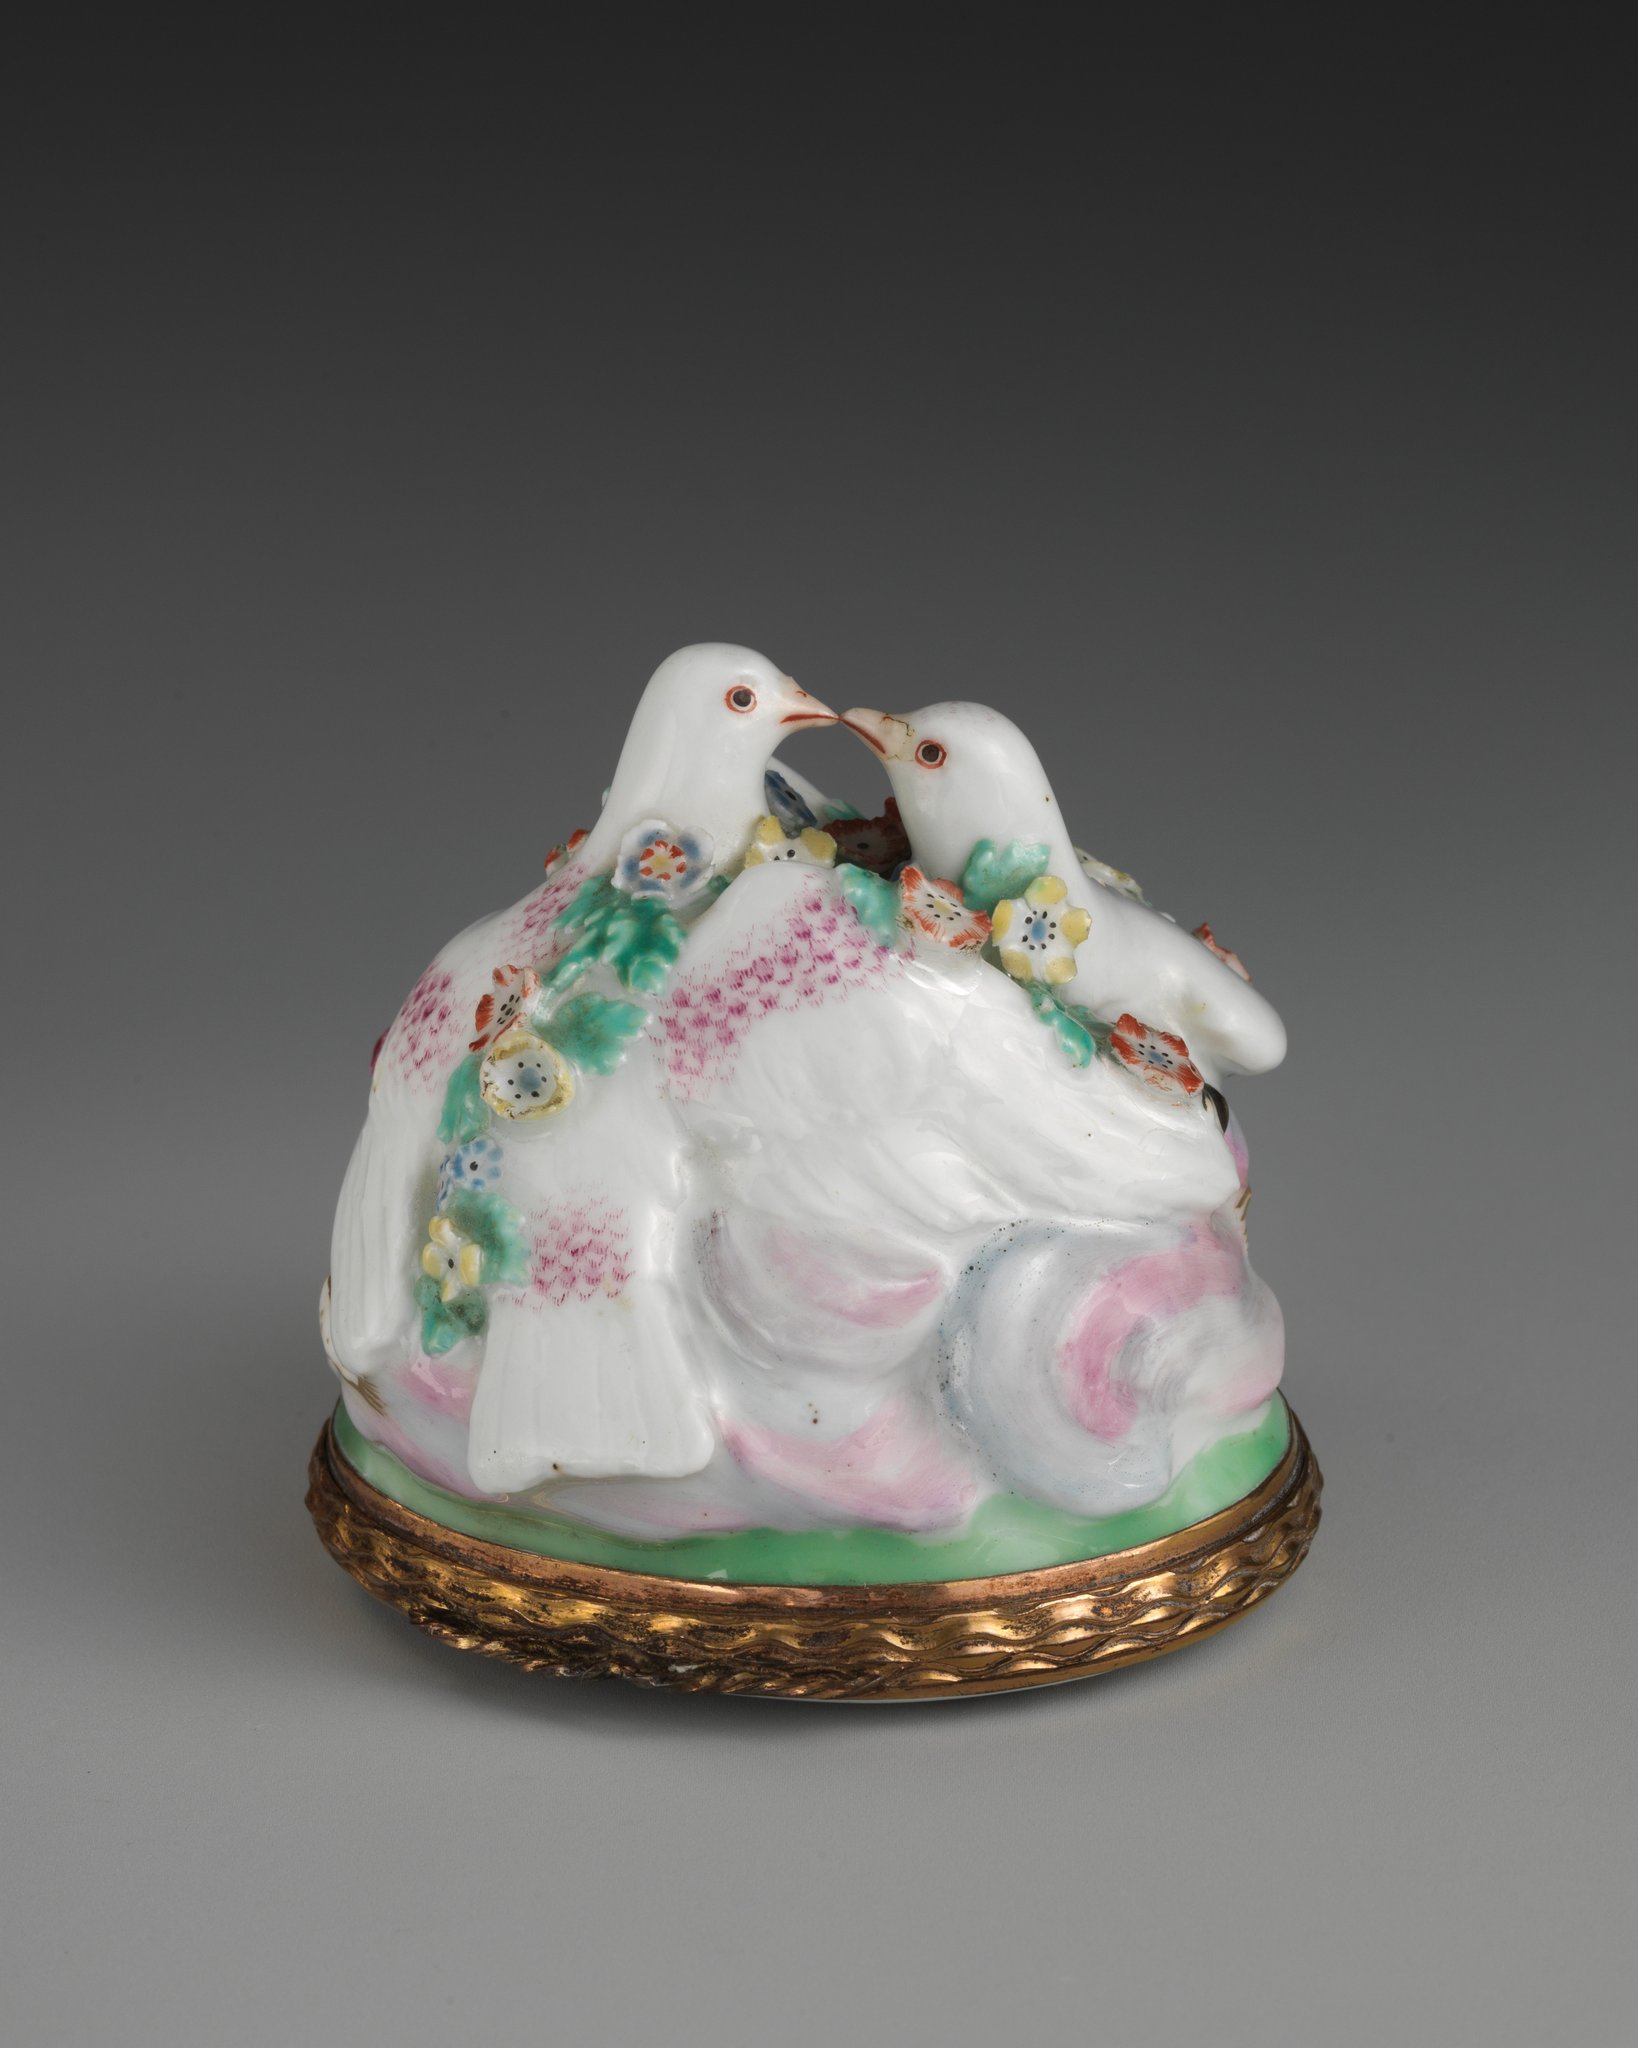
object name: toy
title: Billing doves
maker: chelsea porcelain manufactory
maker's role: factory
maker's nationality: british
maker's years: 1744-1784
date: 1760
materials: soft paste porcelain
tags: doves